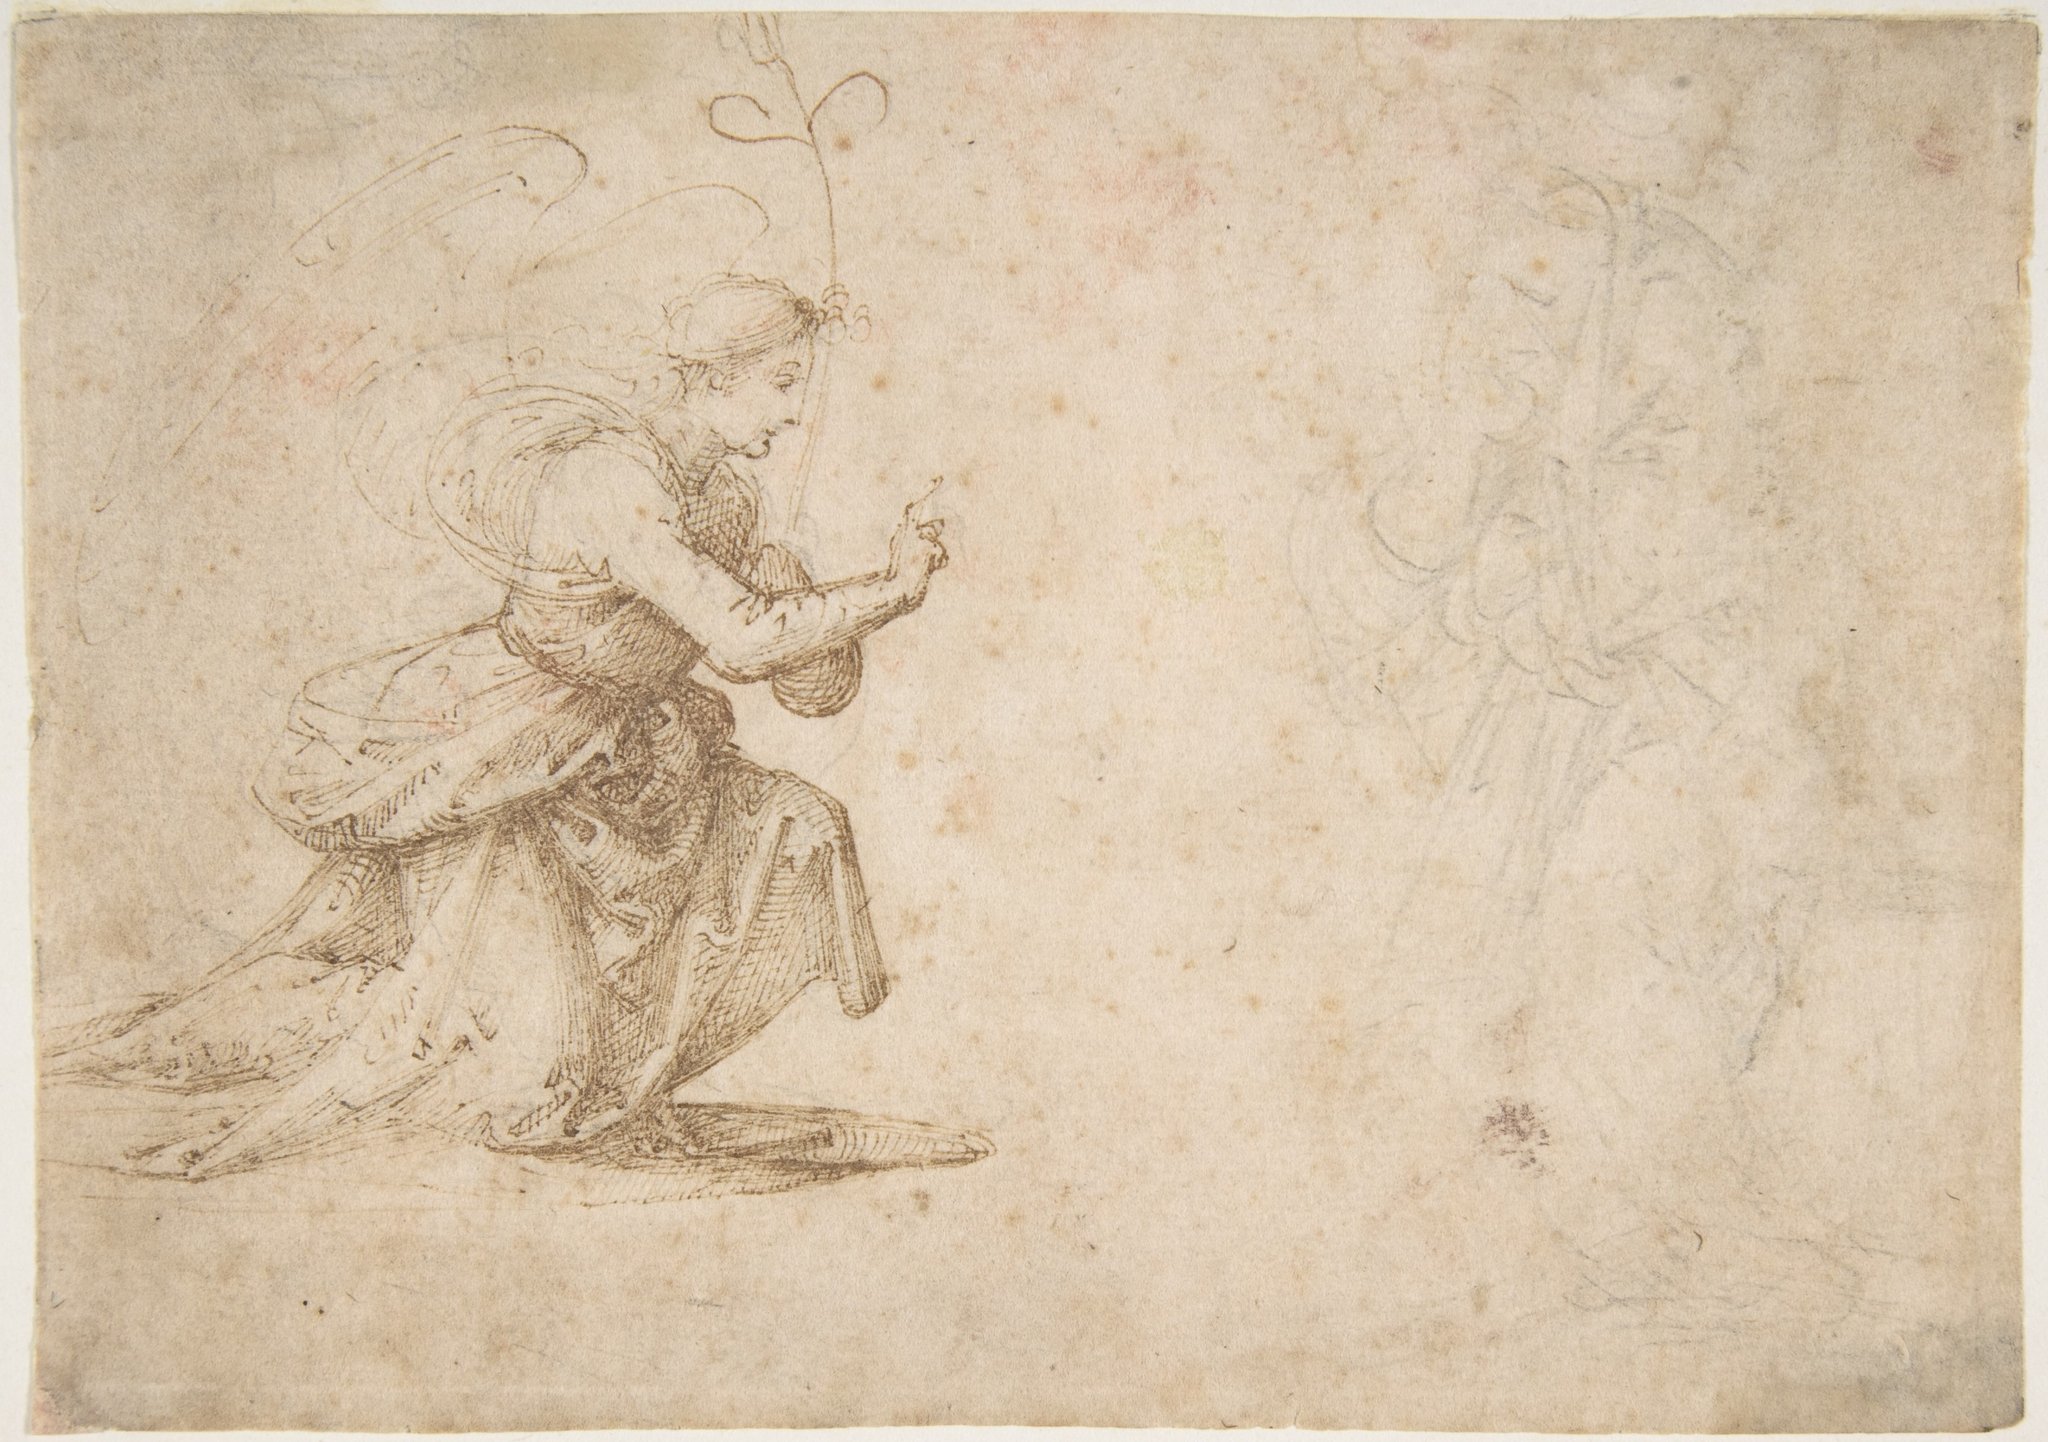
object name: drawing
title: The Annunciation (recto); Faint View of Buildings (verso)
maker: fra bartolomeo (bartolomeo di paolo del fattorino)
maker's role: artist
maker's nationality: italian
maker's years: 1473-1517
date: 1472-1517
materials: chalk, ink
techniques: pen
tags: virgin mary,archangel gabriel,annunciation